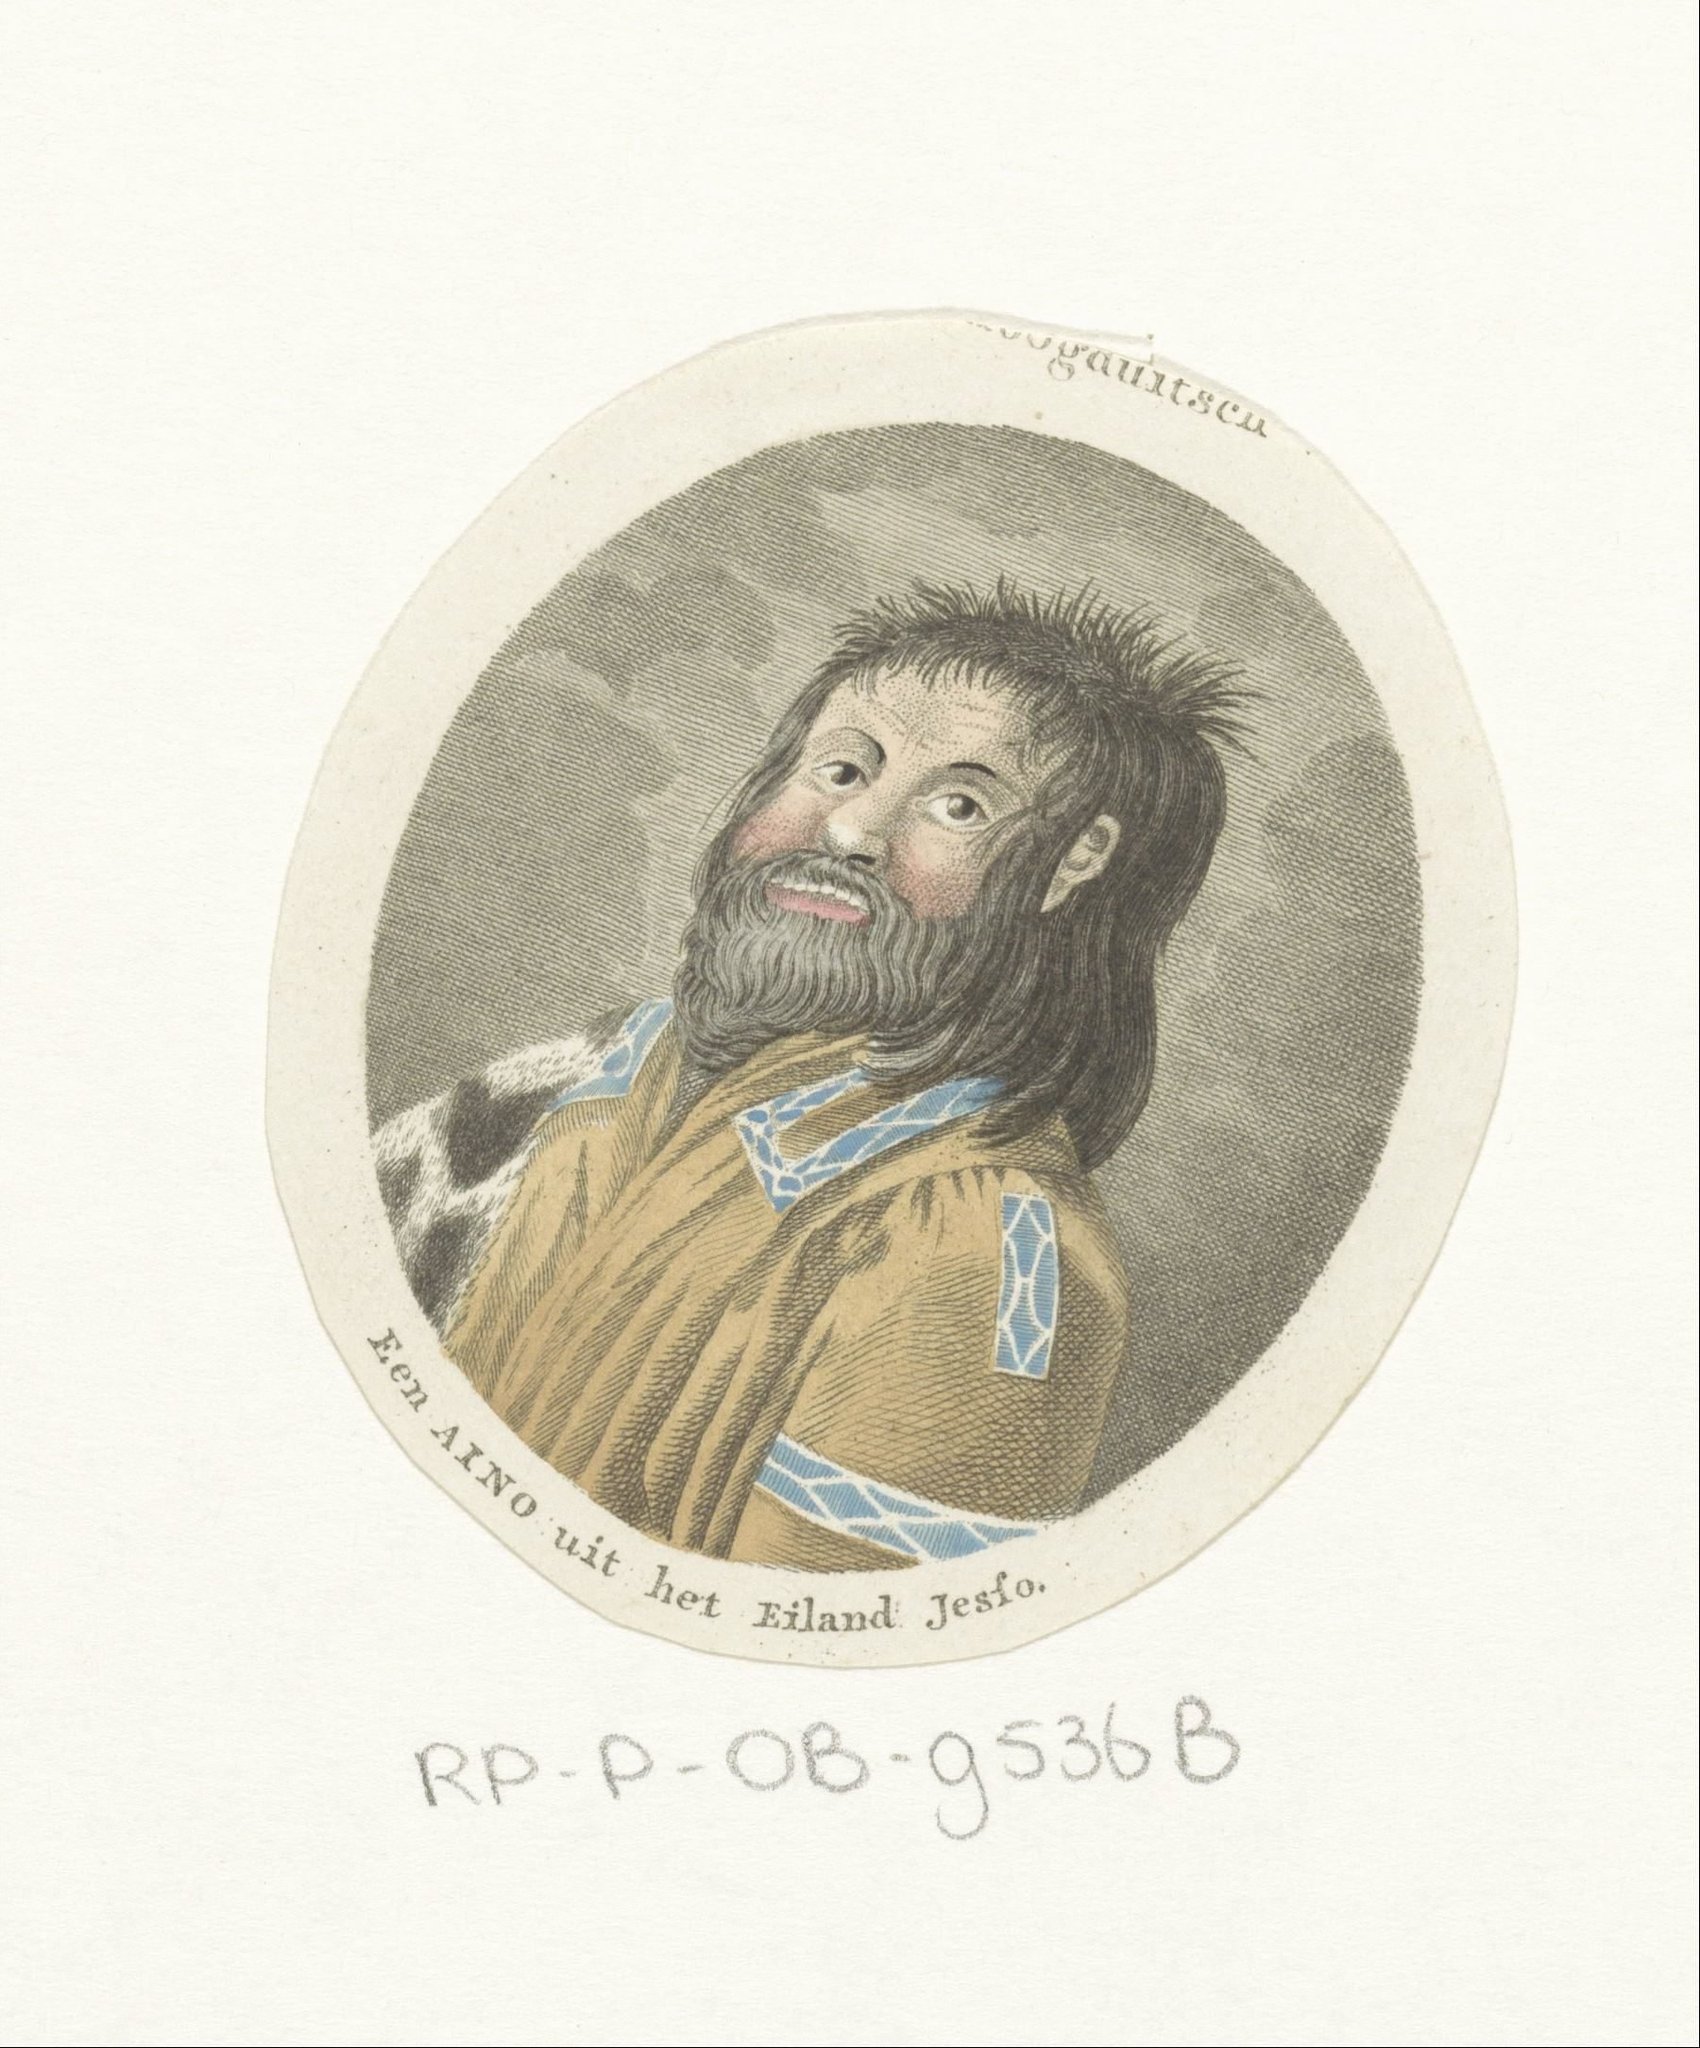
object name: titelblad, titelpagina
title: Titelpagina voor: A.J. von Krusenstern, Reize om de wereld, 1811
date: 1811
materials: paper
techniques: engraving, etching, hand coloring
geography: haarlem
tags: asiatic races and peoples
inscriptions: collector's mark: Lugt 2228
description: Deel van titelpagina voor: Krusenstern, A.J. von. Reize om de wereld, gedaan in de jaren 1803, 1804, 1805 en 1806, op bevel van Alexander den Eersten, keizer van Rusland. Tweede deel. Haarlem: Loosjes, Adriaan Pietersz., 1811.